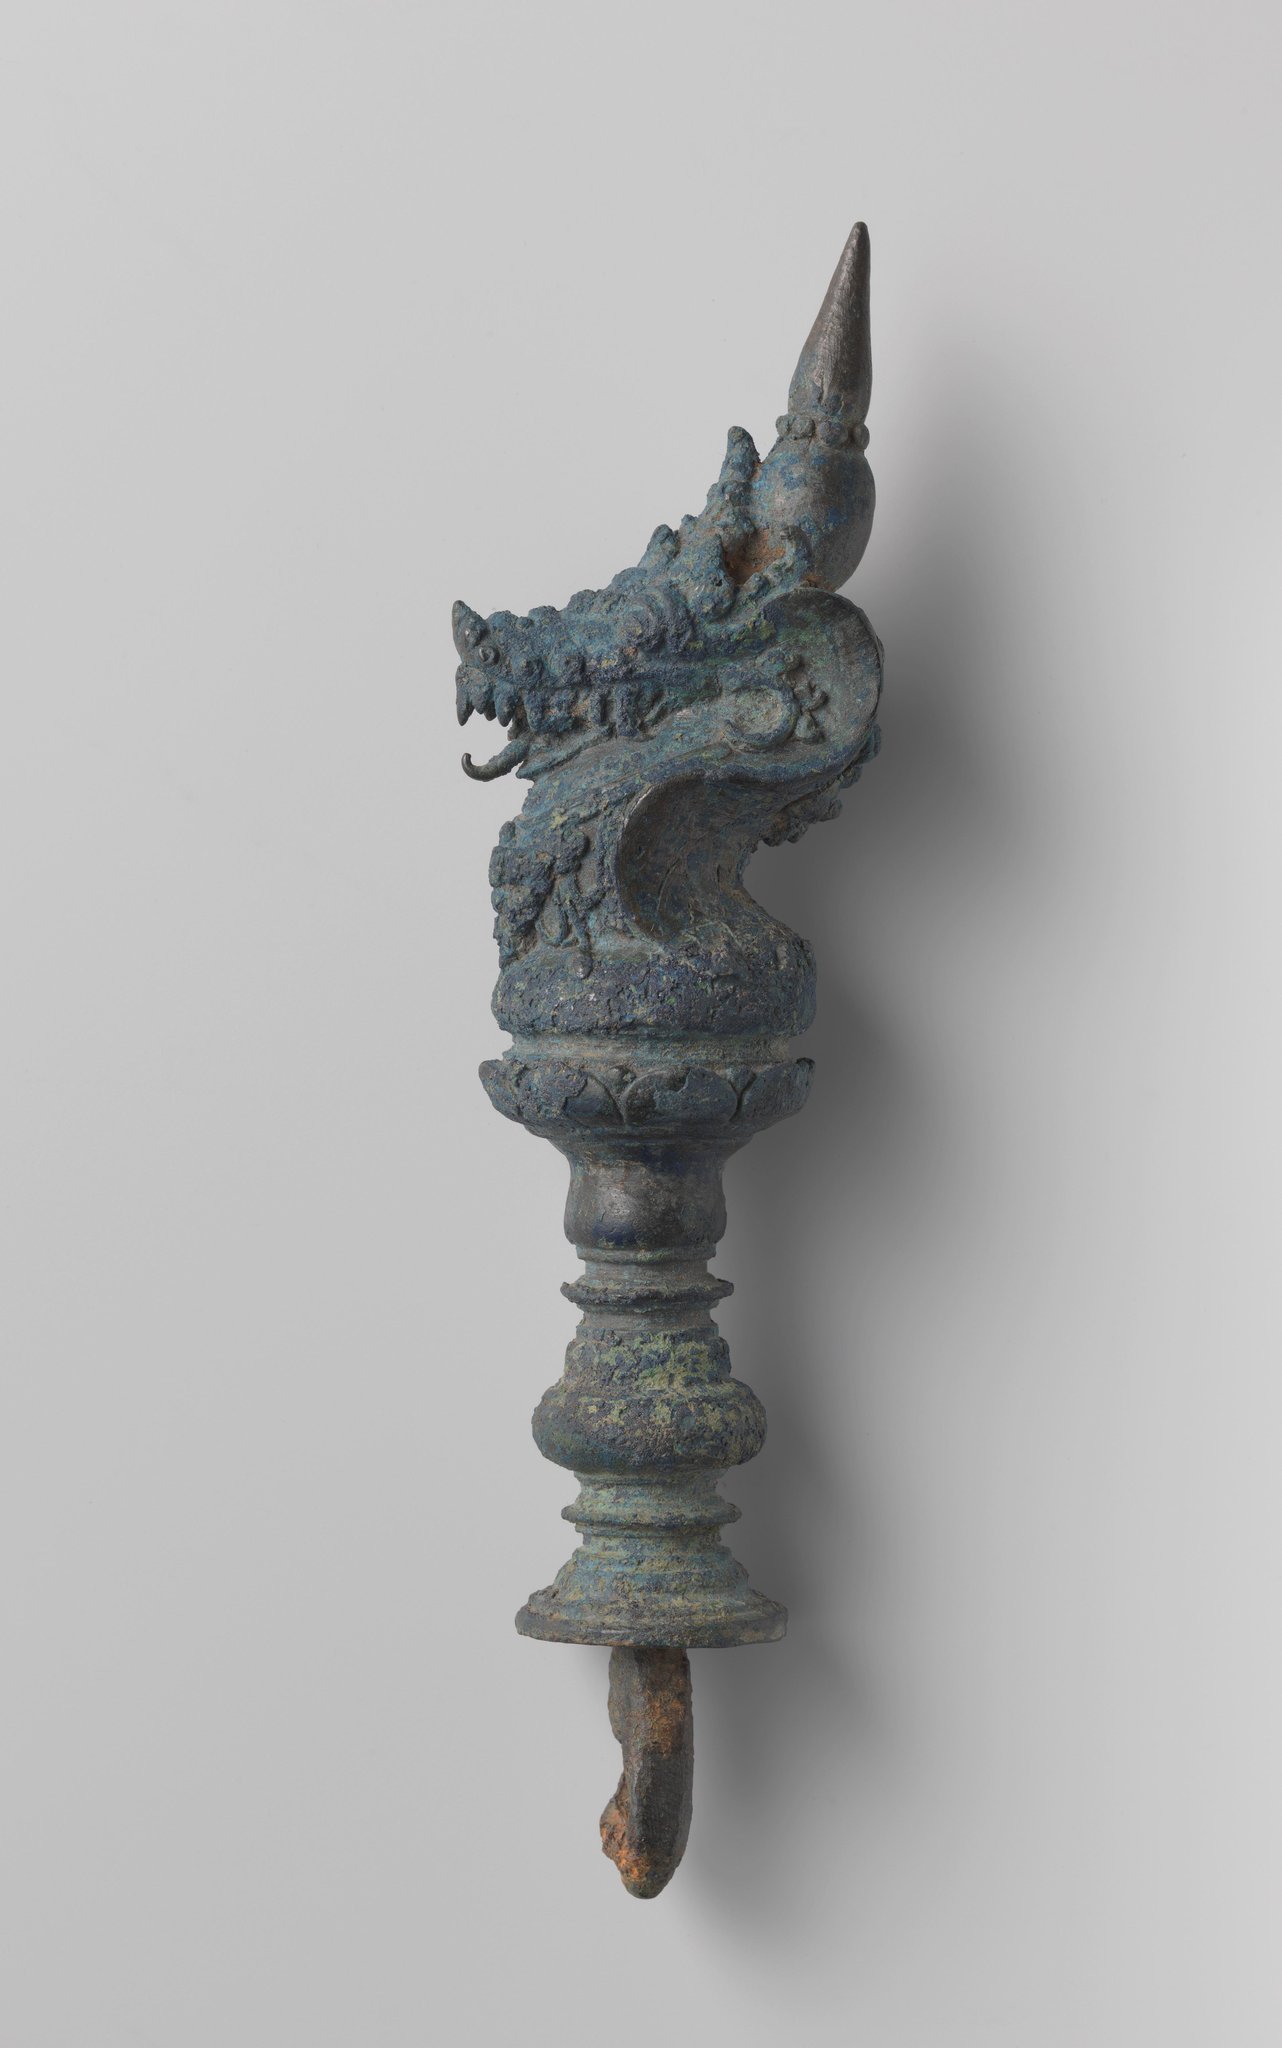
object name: sierstuk, sierobject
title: Sierstuk met slangenkop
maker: Anonymous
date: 1200-1300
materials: bronze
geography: java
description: Bekroning in sde vorm van een slangenkop. Wellicht is deze slangekop de bekroning van een spleettrom.